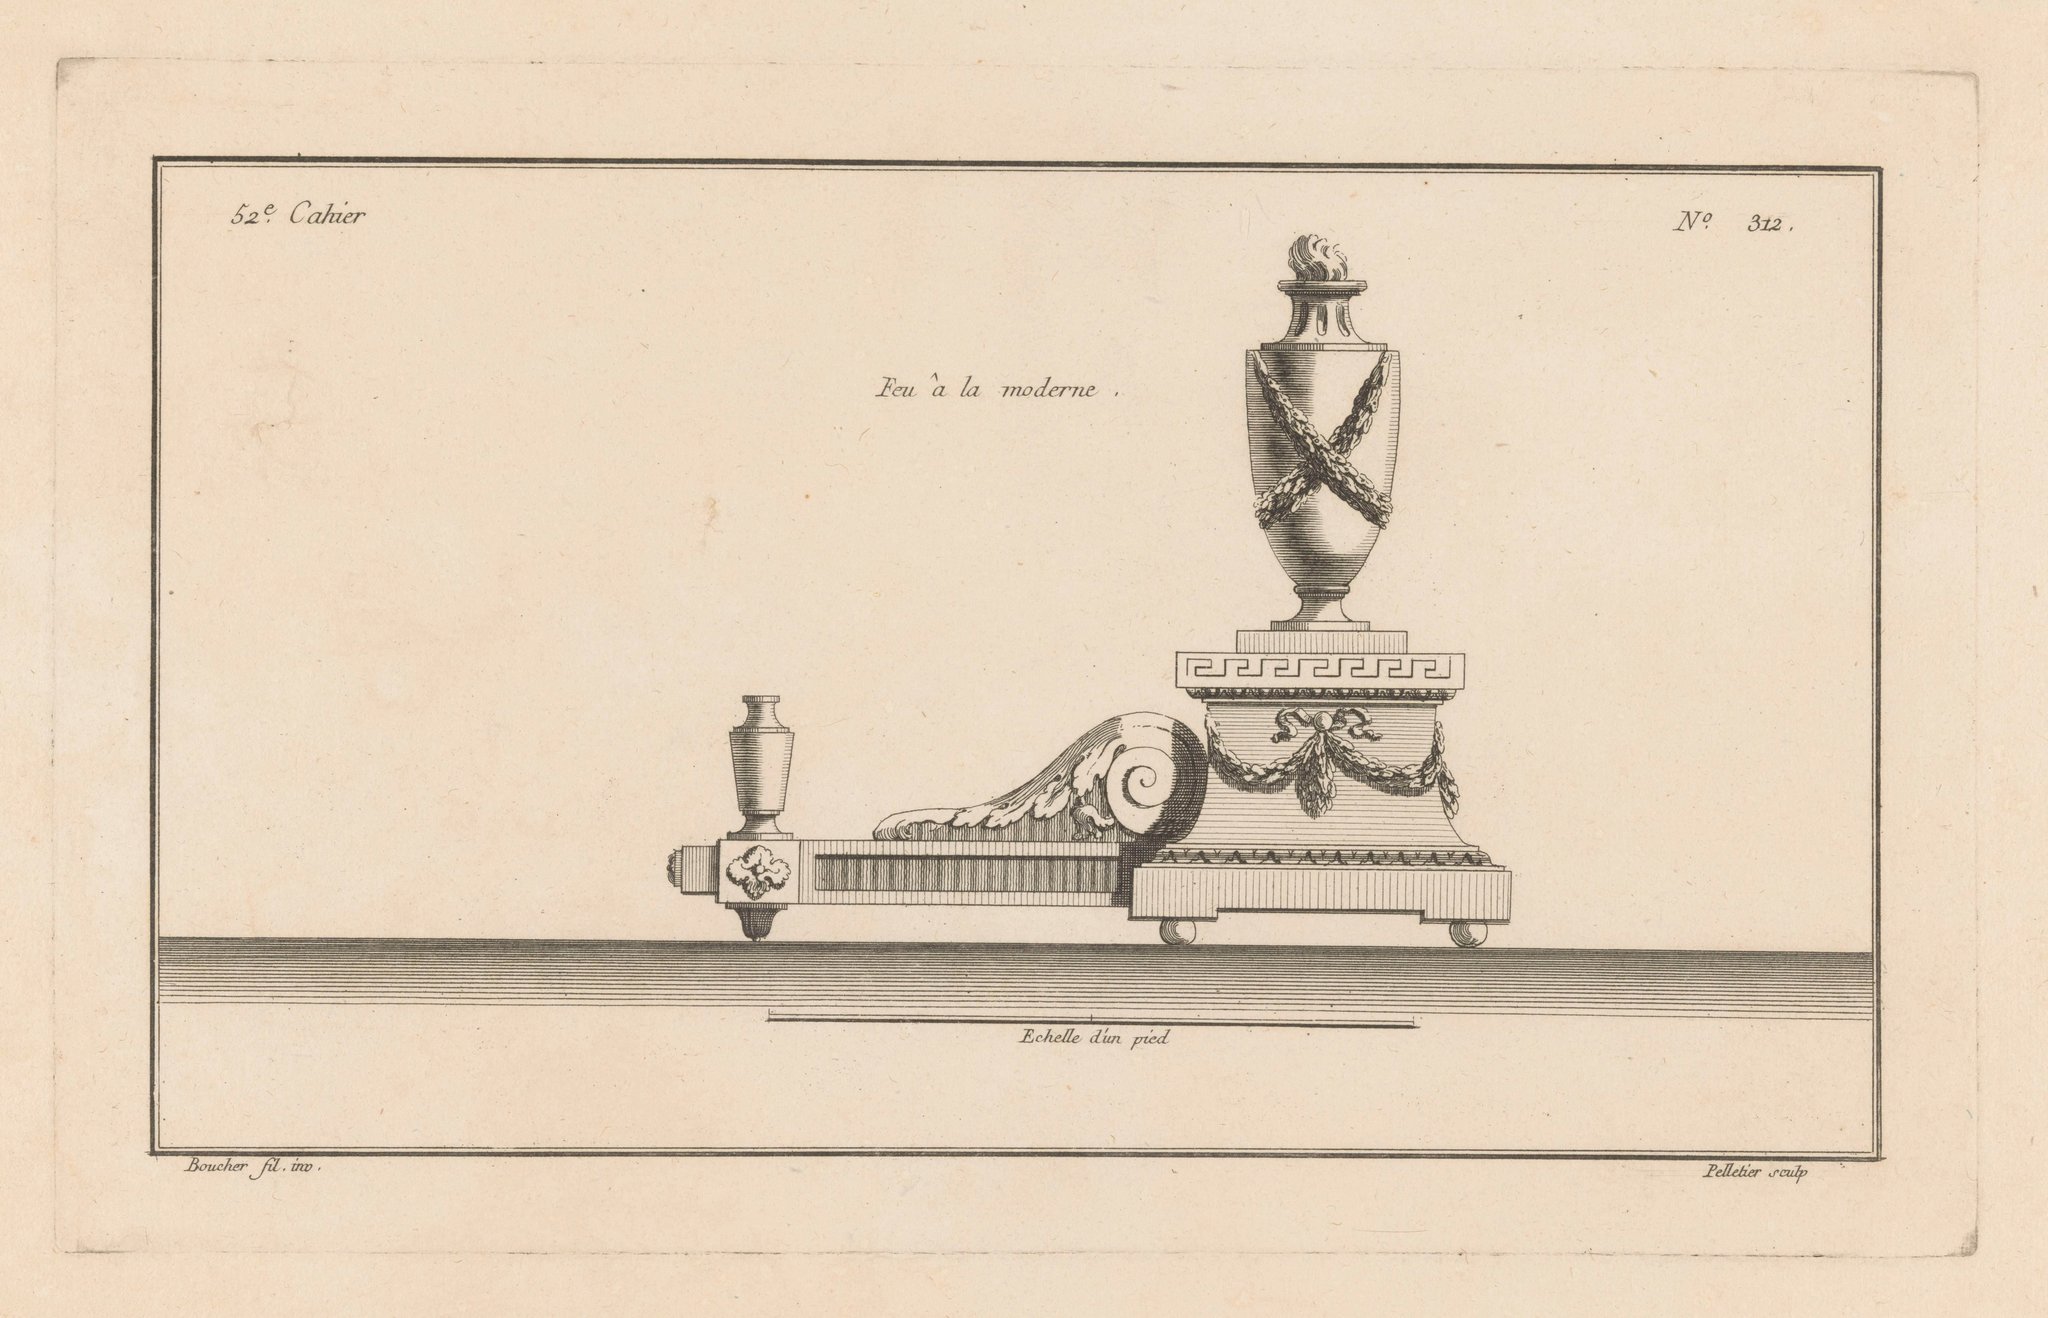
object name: ornament print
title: 52e Cahier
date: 1772-1779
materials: paper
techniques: engraving, etching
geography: paris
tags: andiron, fire-dog, vase ~ ornament, ornament ~ festoon, garland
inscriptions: collector's mark: Lugt 2228, collector's mark: Lugt 2760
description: Een geornamenteerde vuurbok met guirlandes en twee vazen, rechts met vuur. Prentnummer 312.